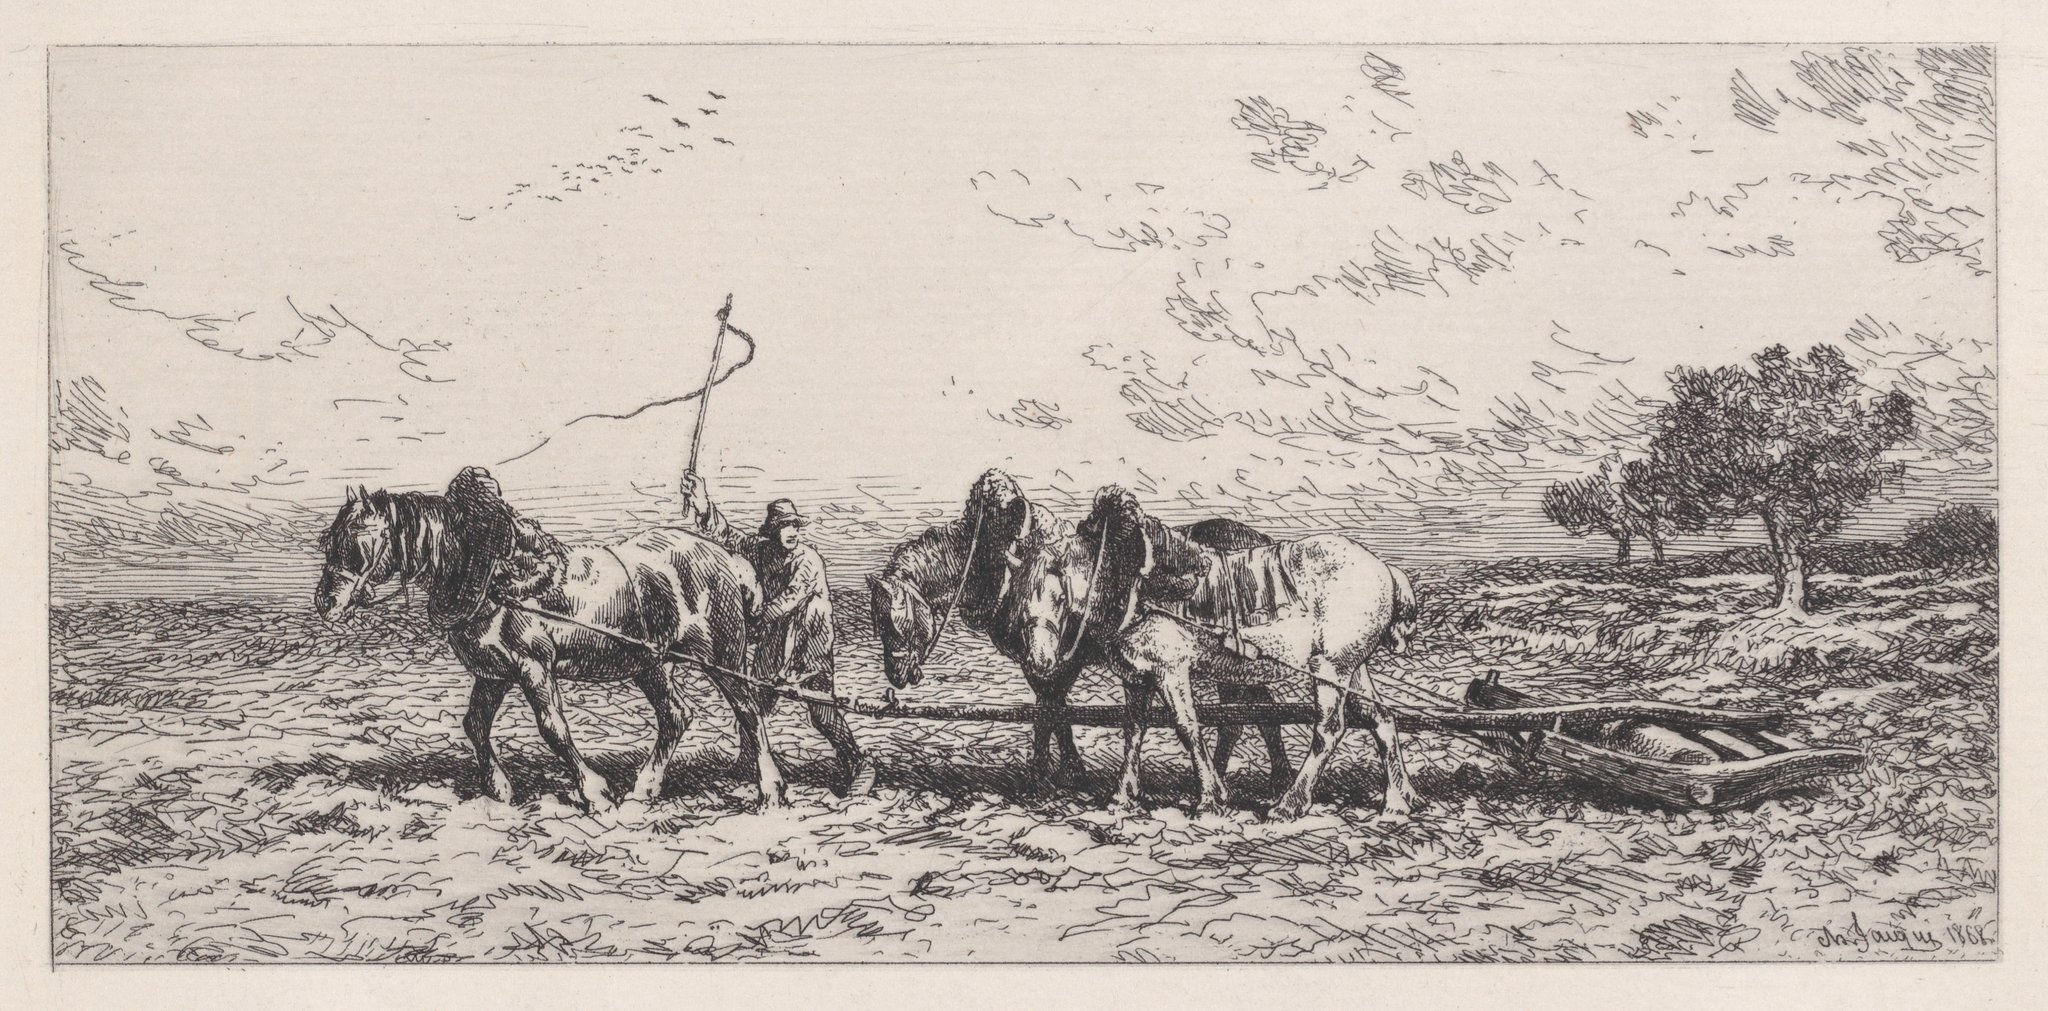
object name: print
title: Le Rouleau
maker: charles émile jacque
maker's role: artist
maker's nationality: french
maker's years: 1813-1894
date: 1868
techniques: etching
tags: men,horses,farmers